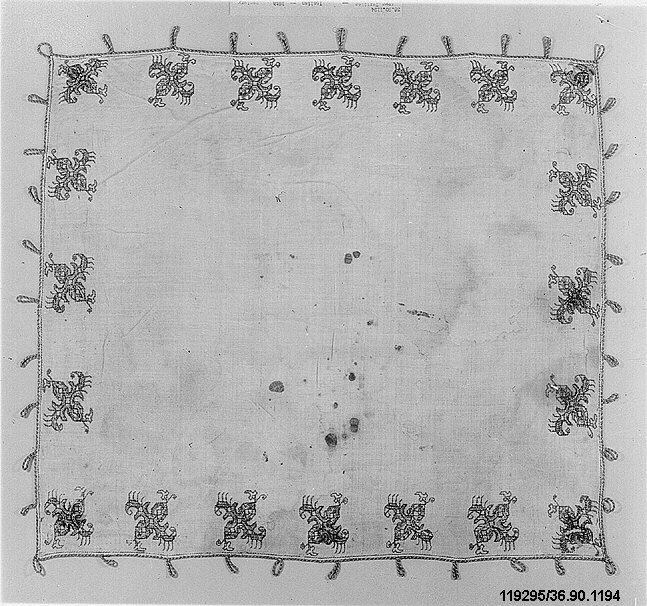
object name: piece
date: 1501-1600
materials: linen, metal thread, silk